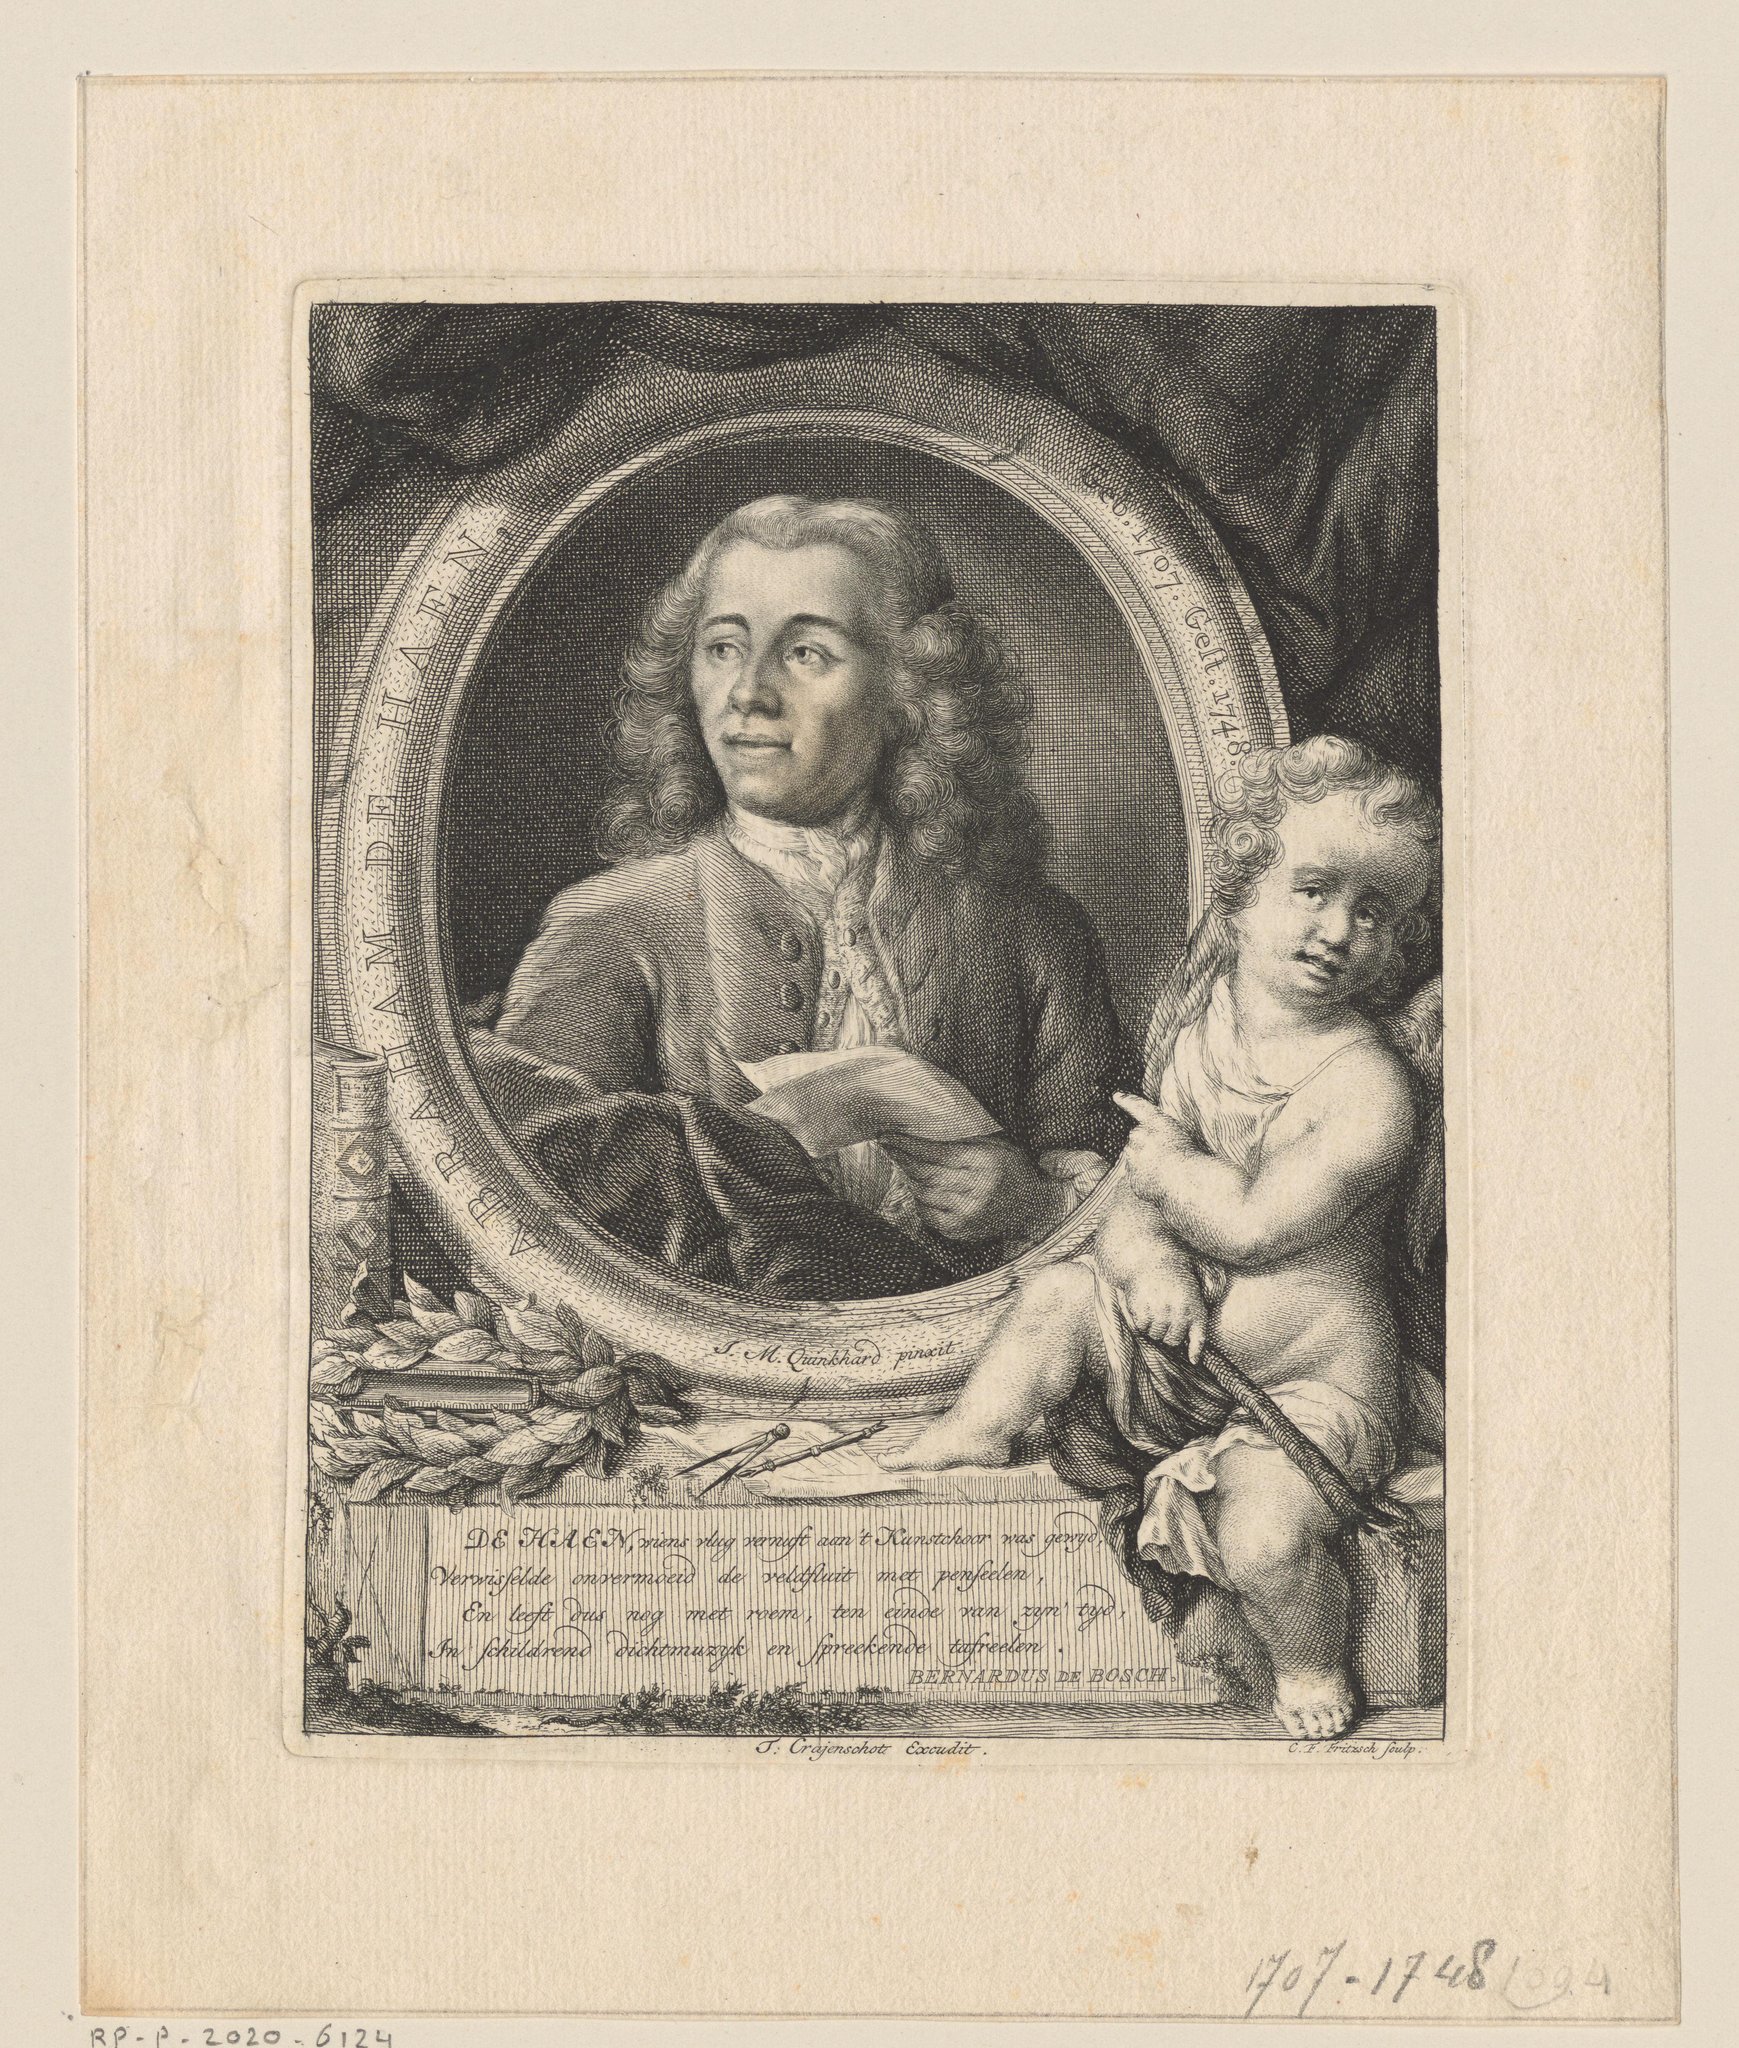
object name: print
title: Portret van Abraham de Haen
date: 1748-1774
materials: paper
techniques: engraving, etching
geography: amsterdam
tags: amsterdam, painter, historical persons, portrait, self-portrait of artist, writer, poet, author, armorial bearing, heraldry